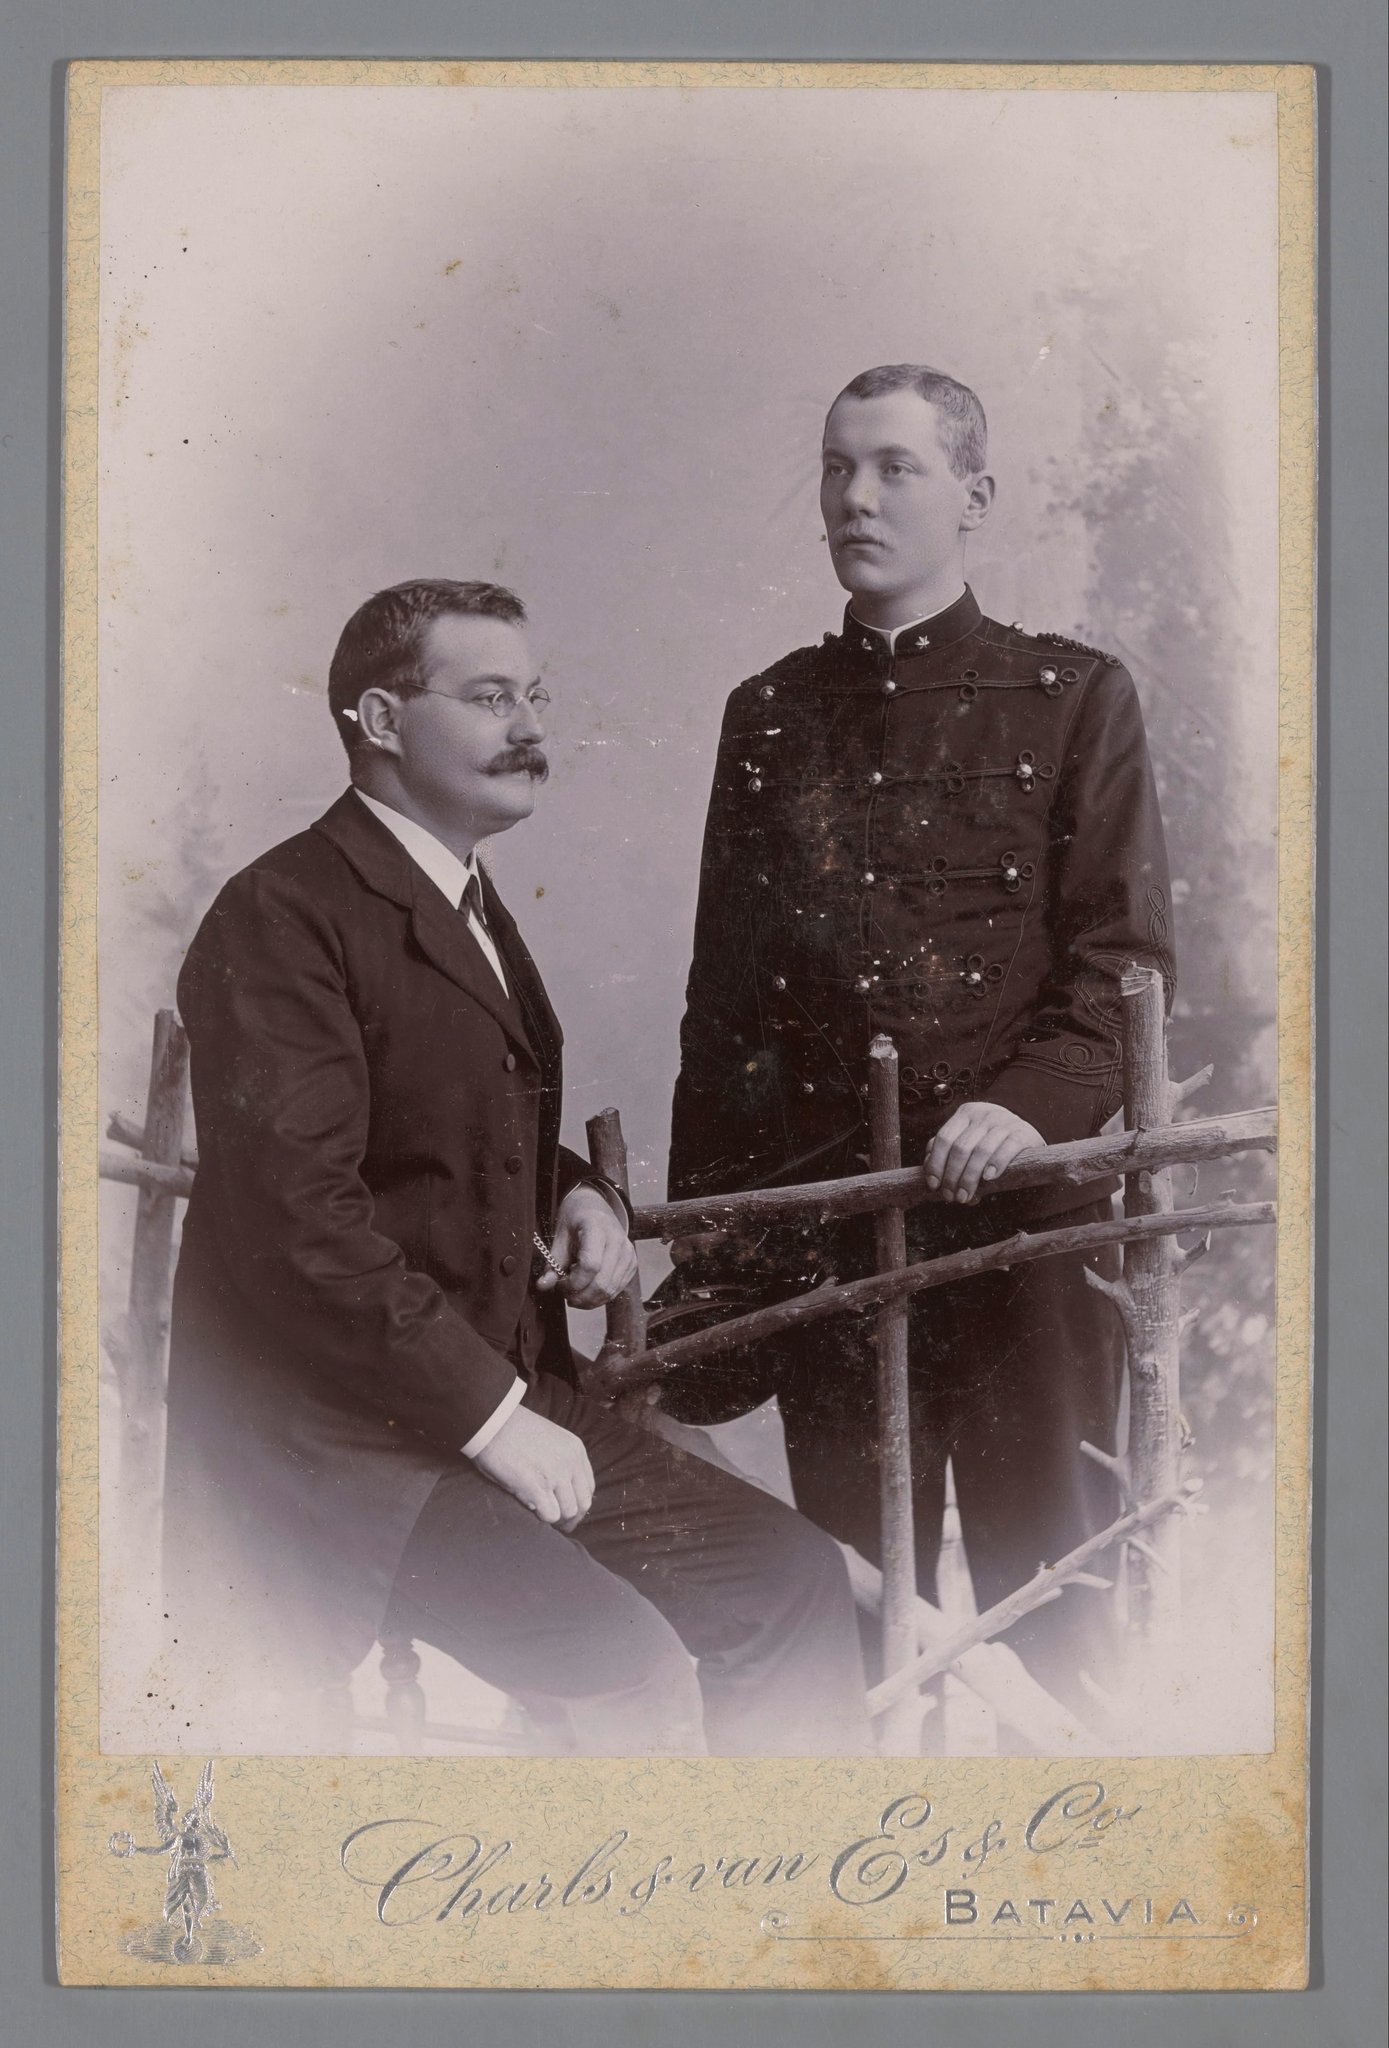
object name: cabinet photograph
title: Portret van twee onbekende mannen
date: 1895-1940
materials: cardboard, photographic support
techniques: collodion silver print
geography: batavia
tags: studio requisites ~ photographer, adult man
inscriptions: name: ‘Photografie Charls & van Es & Co Batavia (...)’, inscription: ‘papa.’